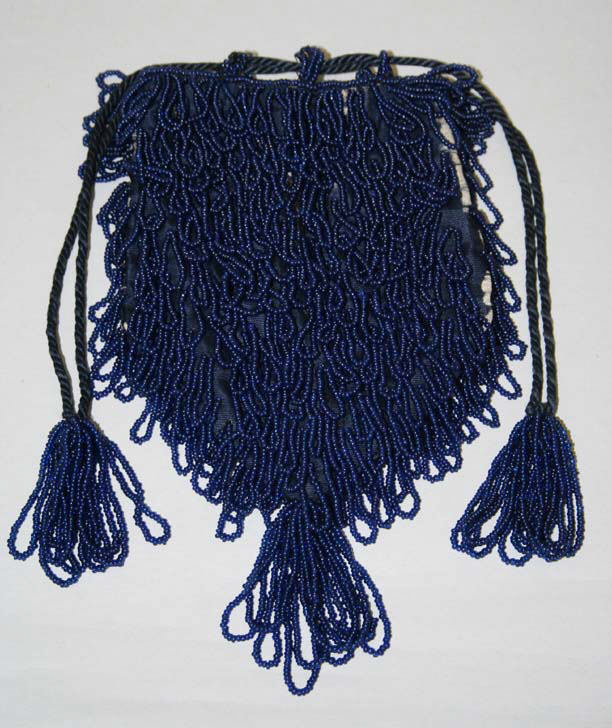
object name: drawstring bag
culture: american or european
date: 1900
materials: glass, silk